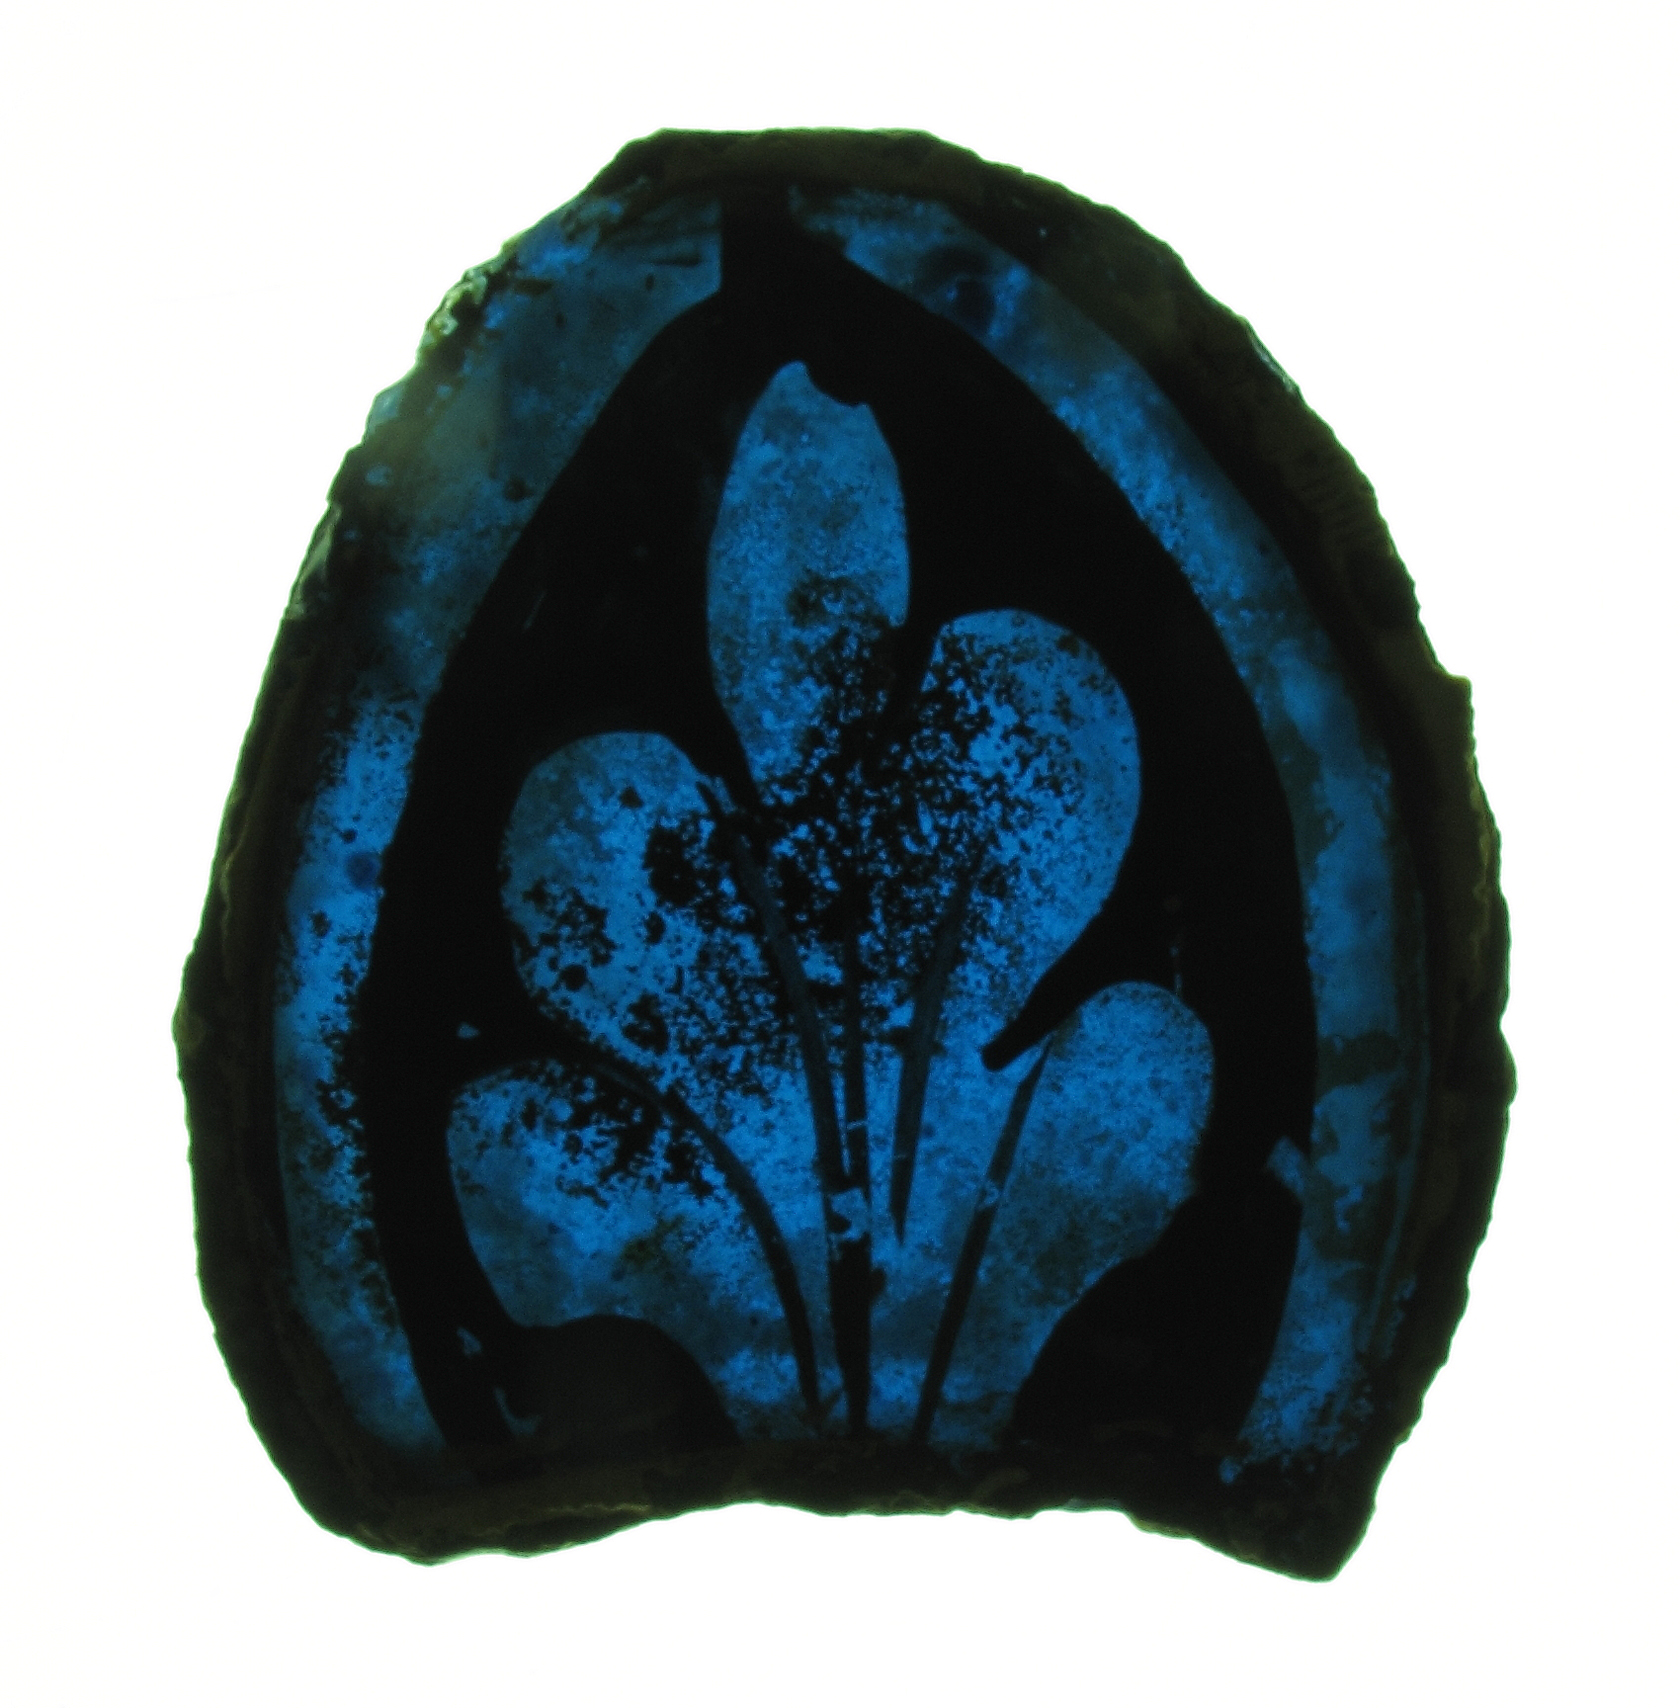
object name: fragment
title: Glass Fragment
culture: european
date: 1201-1300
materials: glass, metal